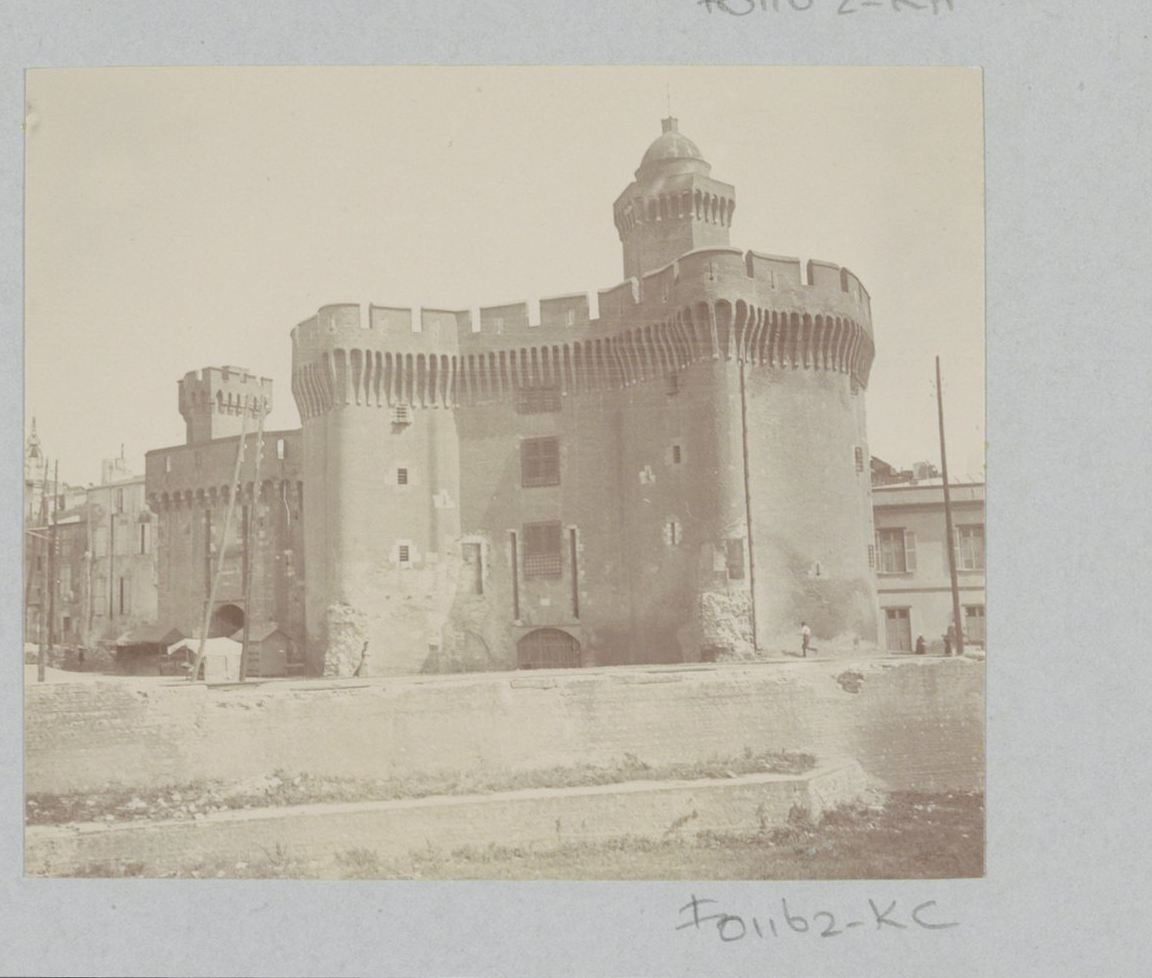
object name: photograph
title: Exterieur van een burcht, vermoedelijk in de Pyreneeën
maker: Anonymous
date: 1905-1910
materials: paper, photographic support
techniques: gelatin silver print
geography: pyrenees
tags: fortress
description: Onderdeel van Fotoalbum van een Franse amateurfotograaf met bezienswaardigheden in Frankrijk, Zwitserland en Italië.